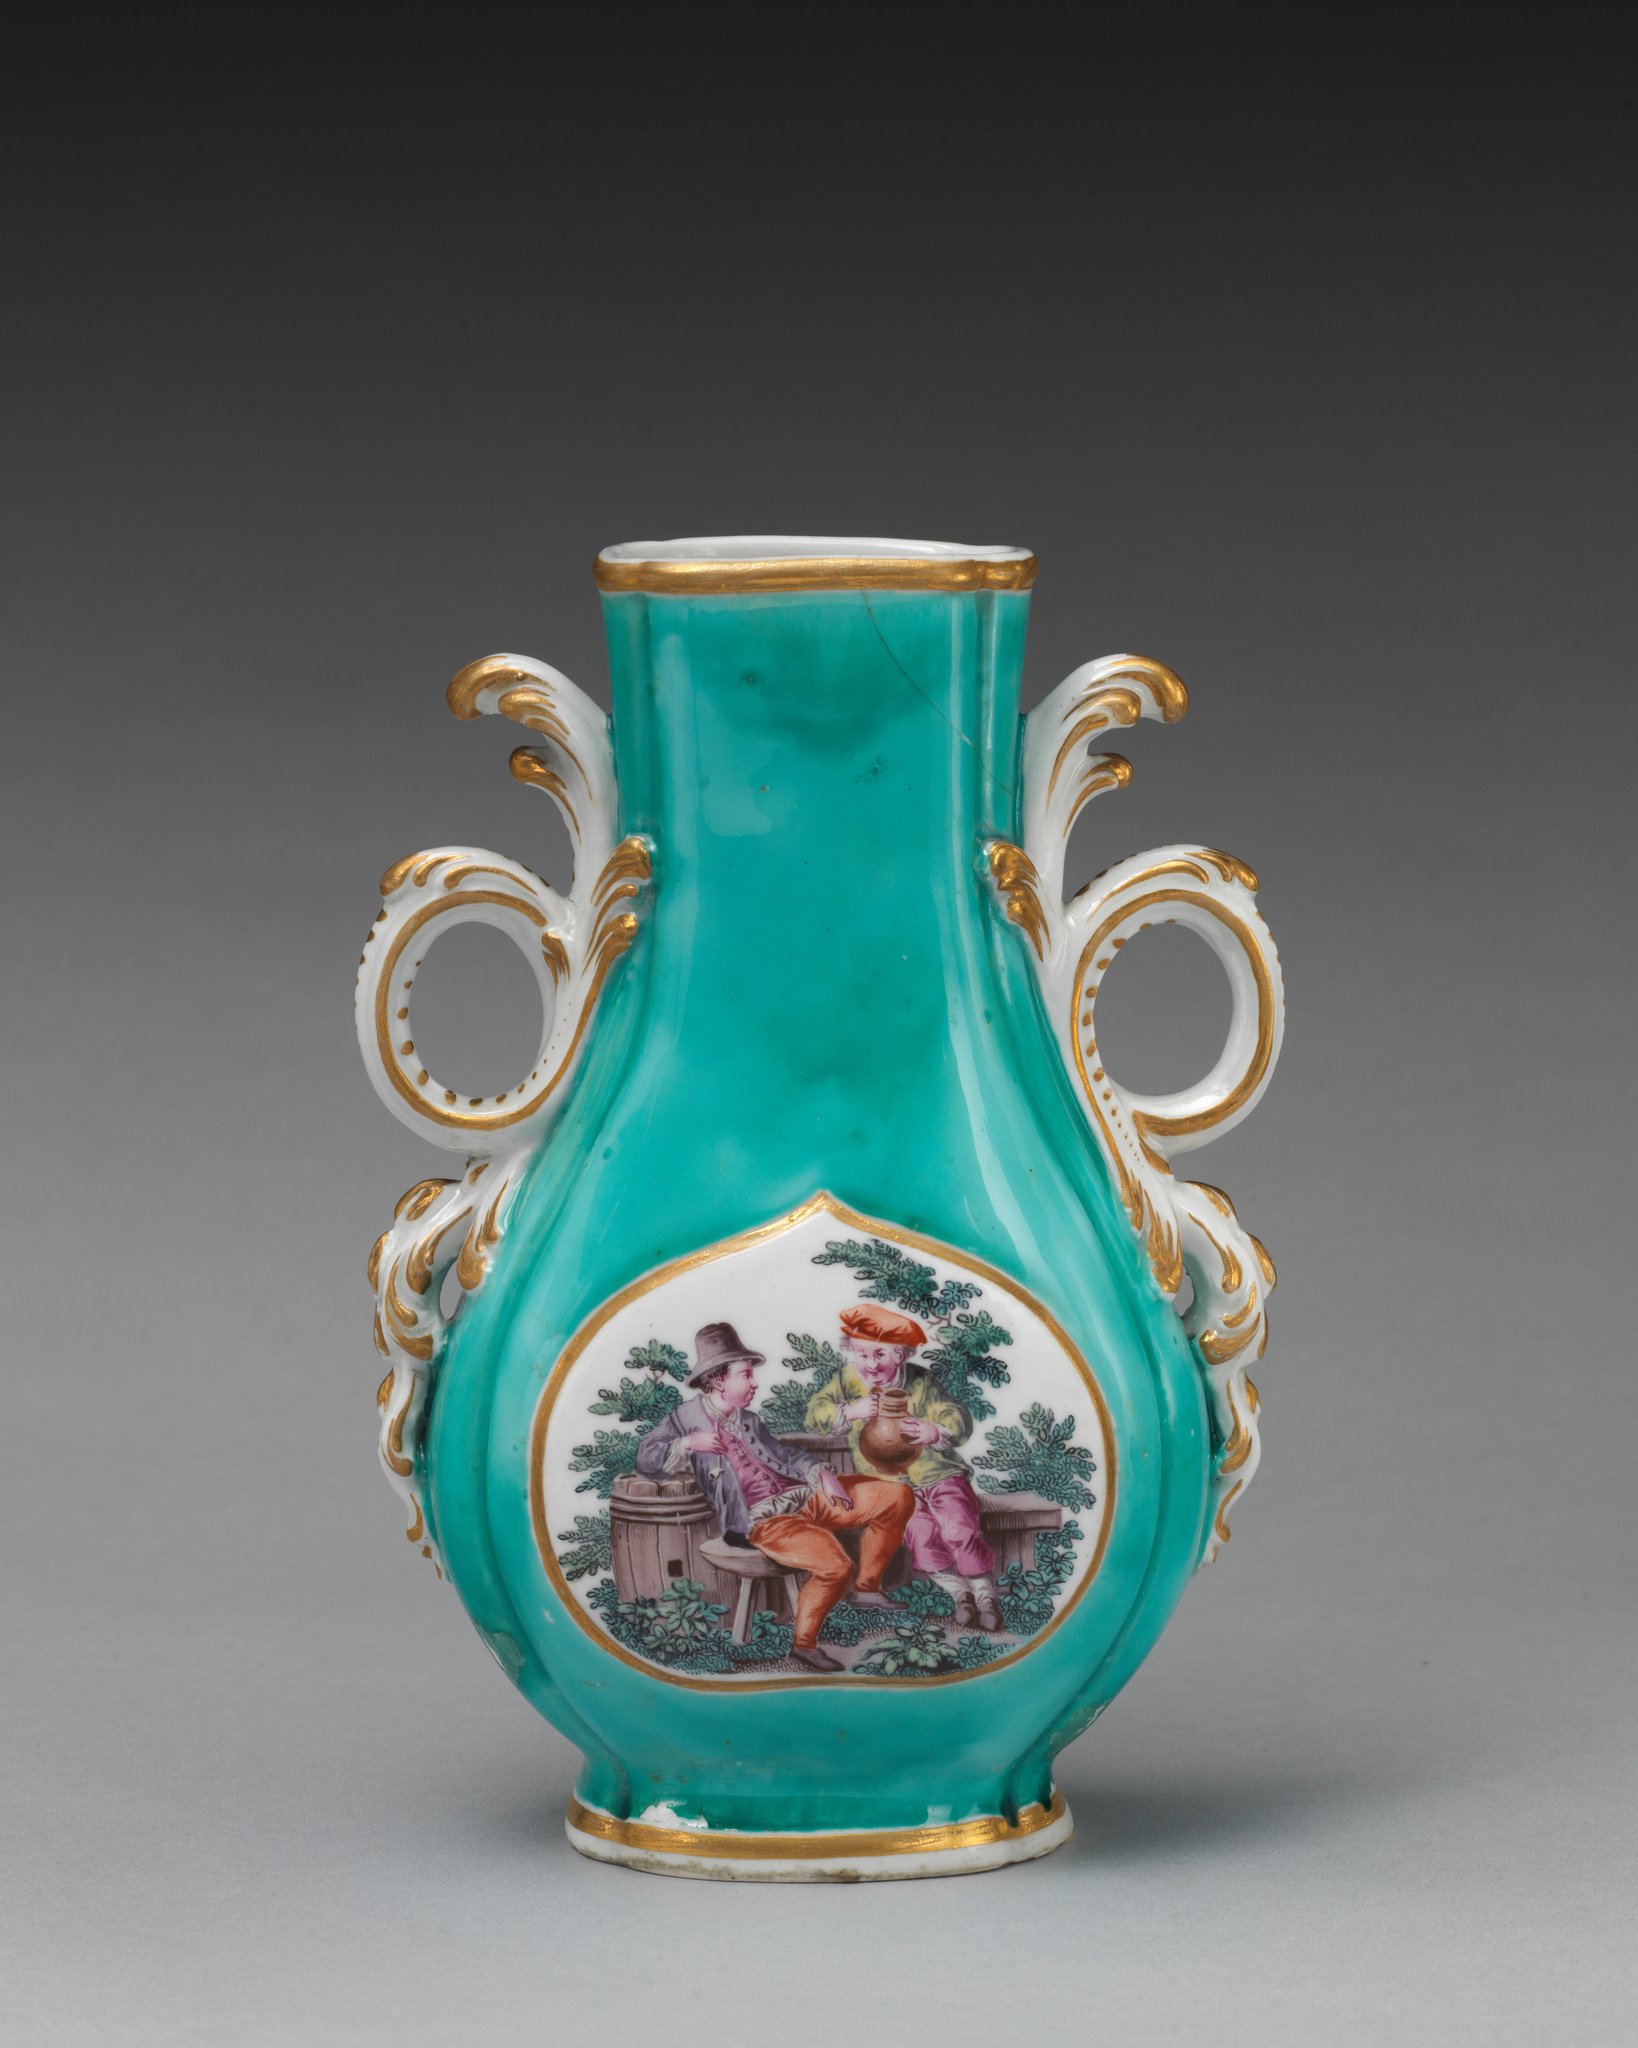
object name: vase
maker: chelsea porcelain manufactory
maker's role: factory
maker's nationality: british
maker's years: 1744-1784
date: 1760-1765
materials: soft paste porcelain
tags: men